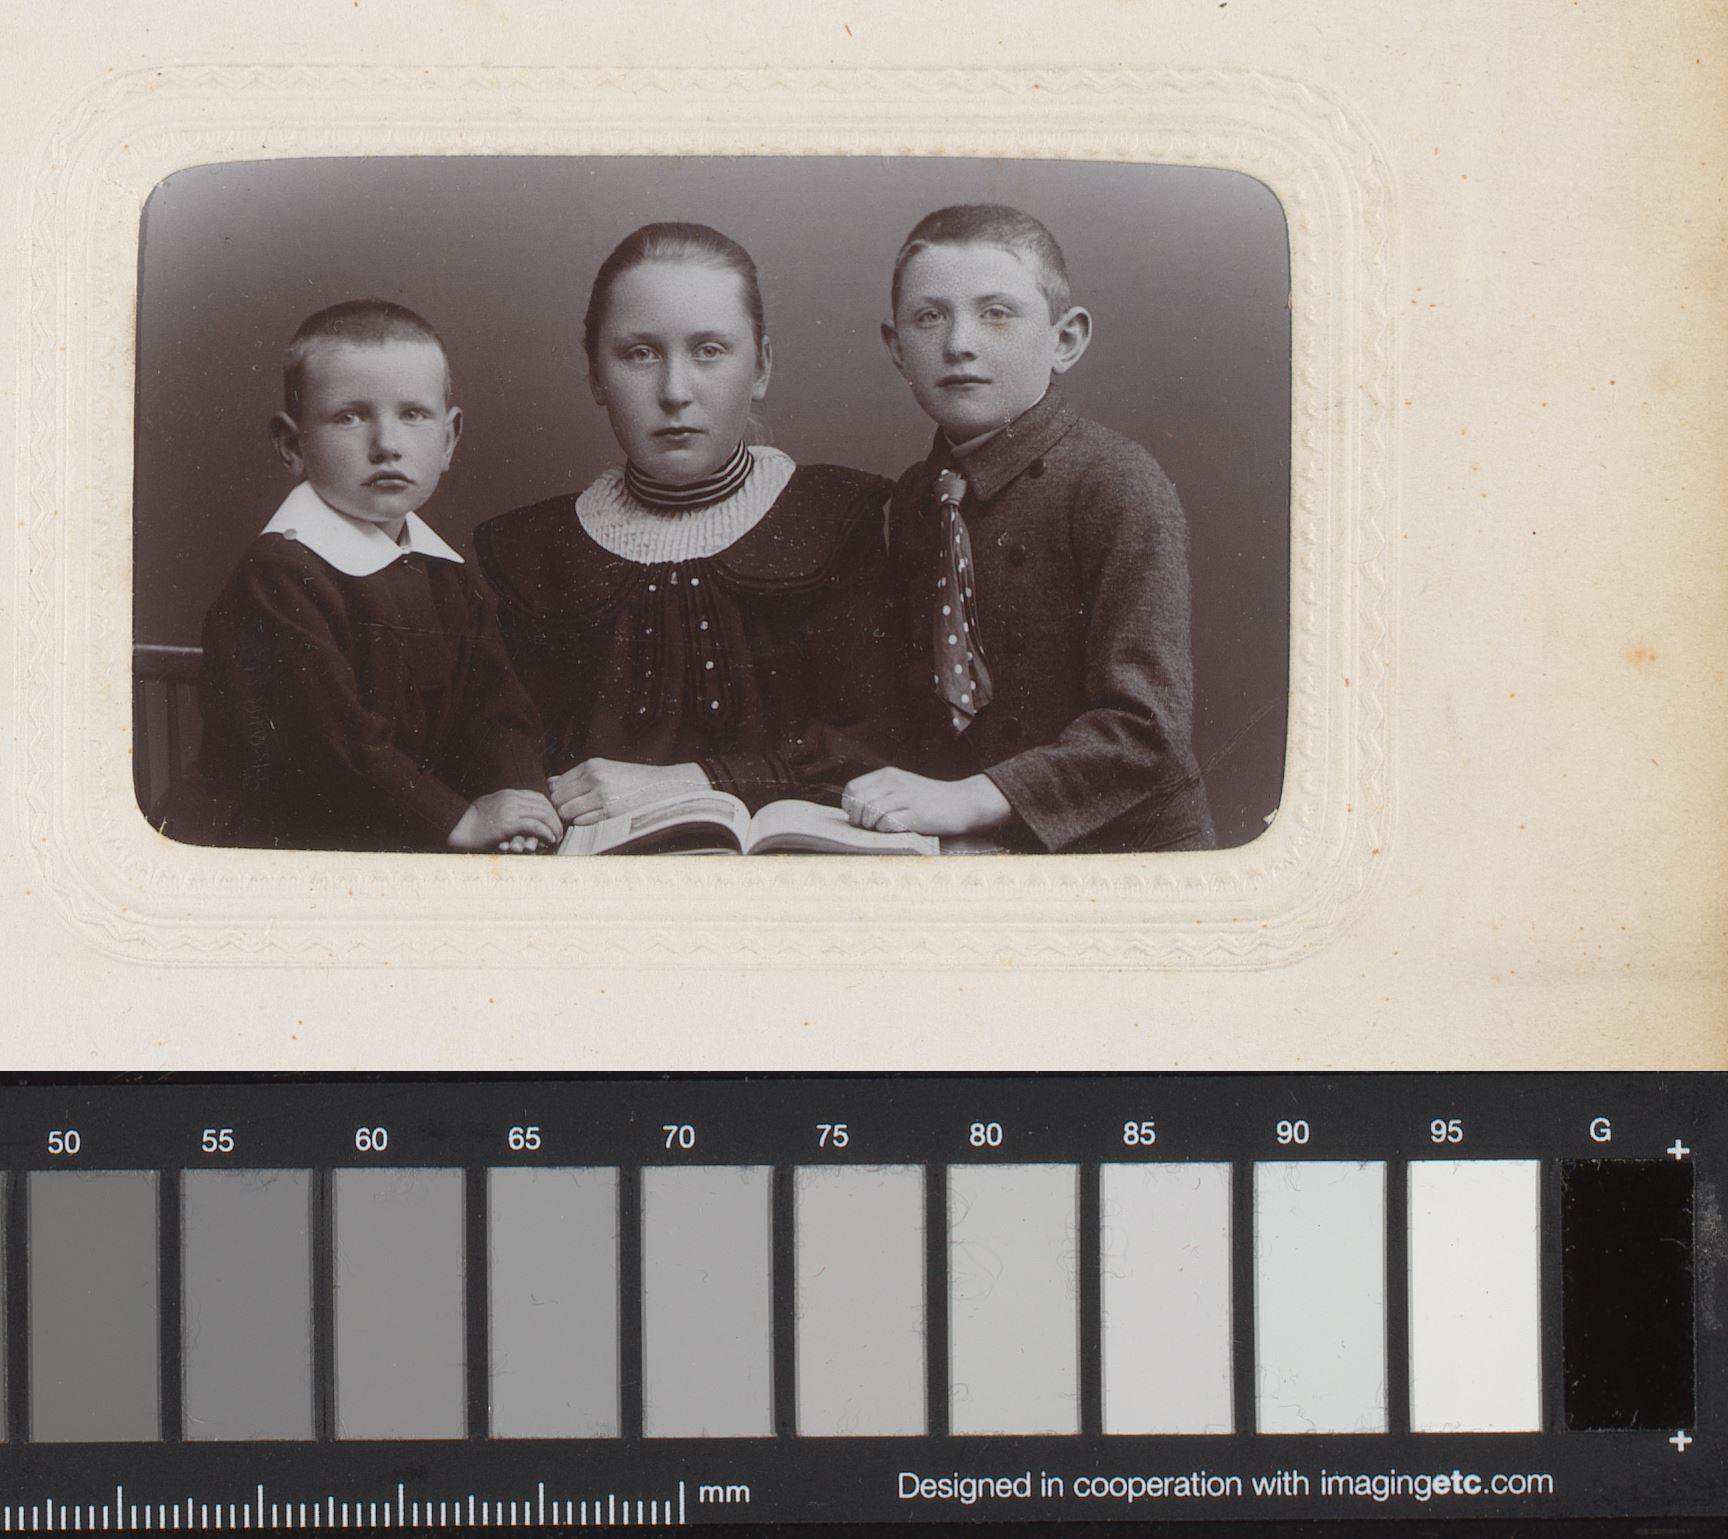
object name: album leaf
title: Portret van een meisje en twee jongens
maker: otto barkhausen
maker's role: fotograaf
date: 1850-1900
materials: cardboard, photographic support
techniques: collodion silver print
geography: wilhelmshaven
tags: boy (child between toddler and youth) (+ two persons), girl (child between toddler and youth), anonymous historical persons portrayed in a group, in a group-portrait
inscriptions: inscription: ‘Photograph./ Atelier/ Otto Barkhausen/ Wilhelmshaven/ Bismarckstr[...]’